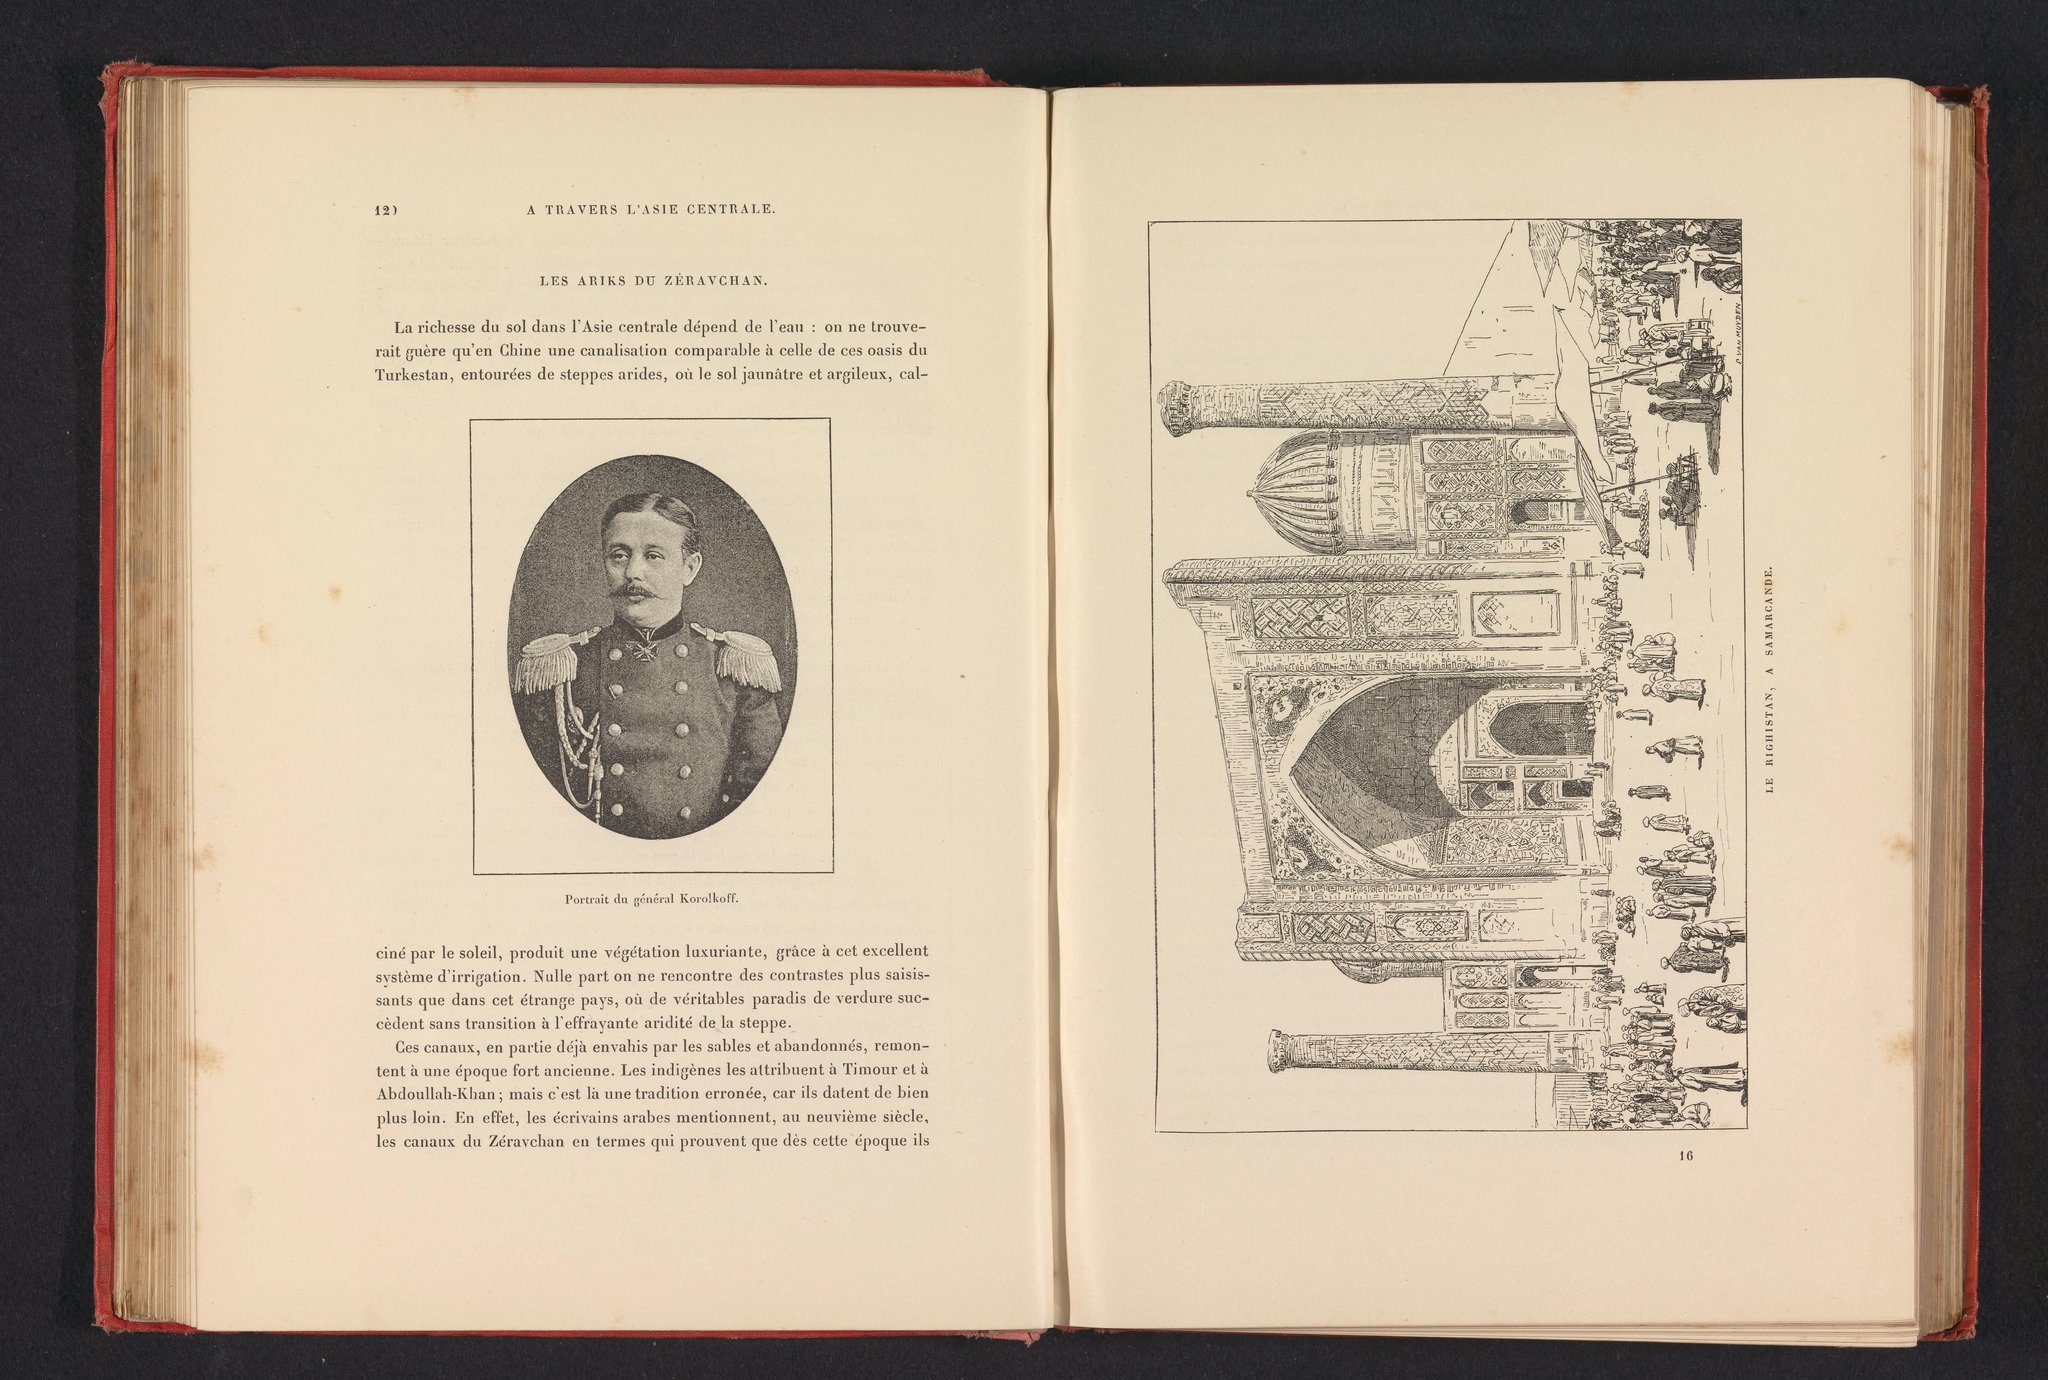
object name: photomechanical print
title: Fragment d'ornement de la Chah-Sindeh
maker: Anonymous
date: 1869-1885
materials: paper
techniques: autotype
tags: commander-in-chief, general, marshal